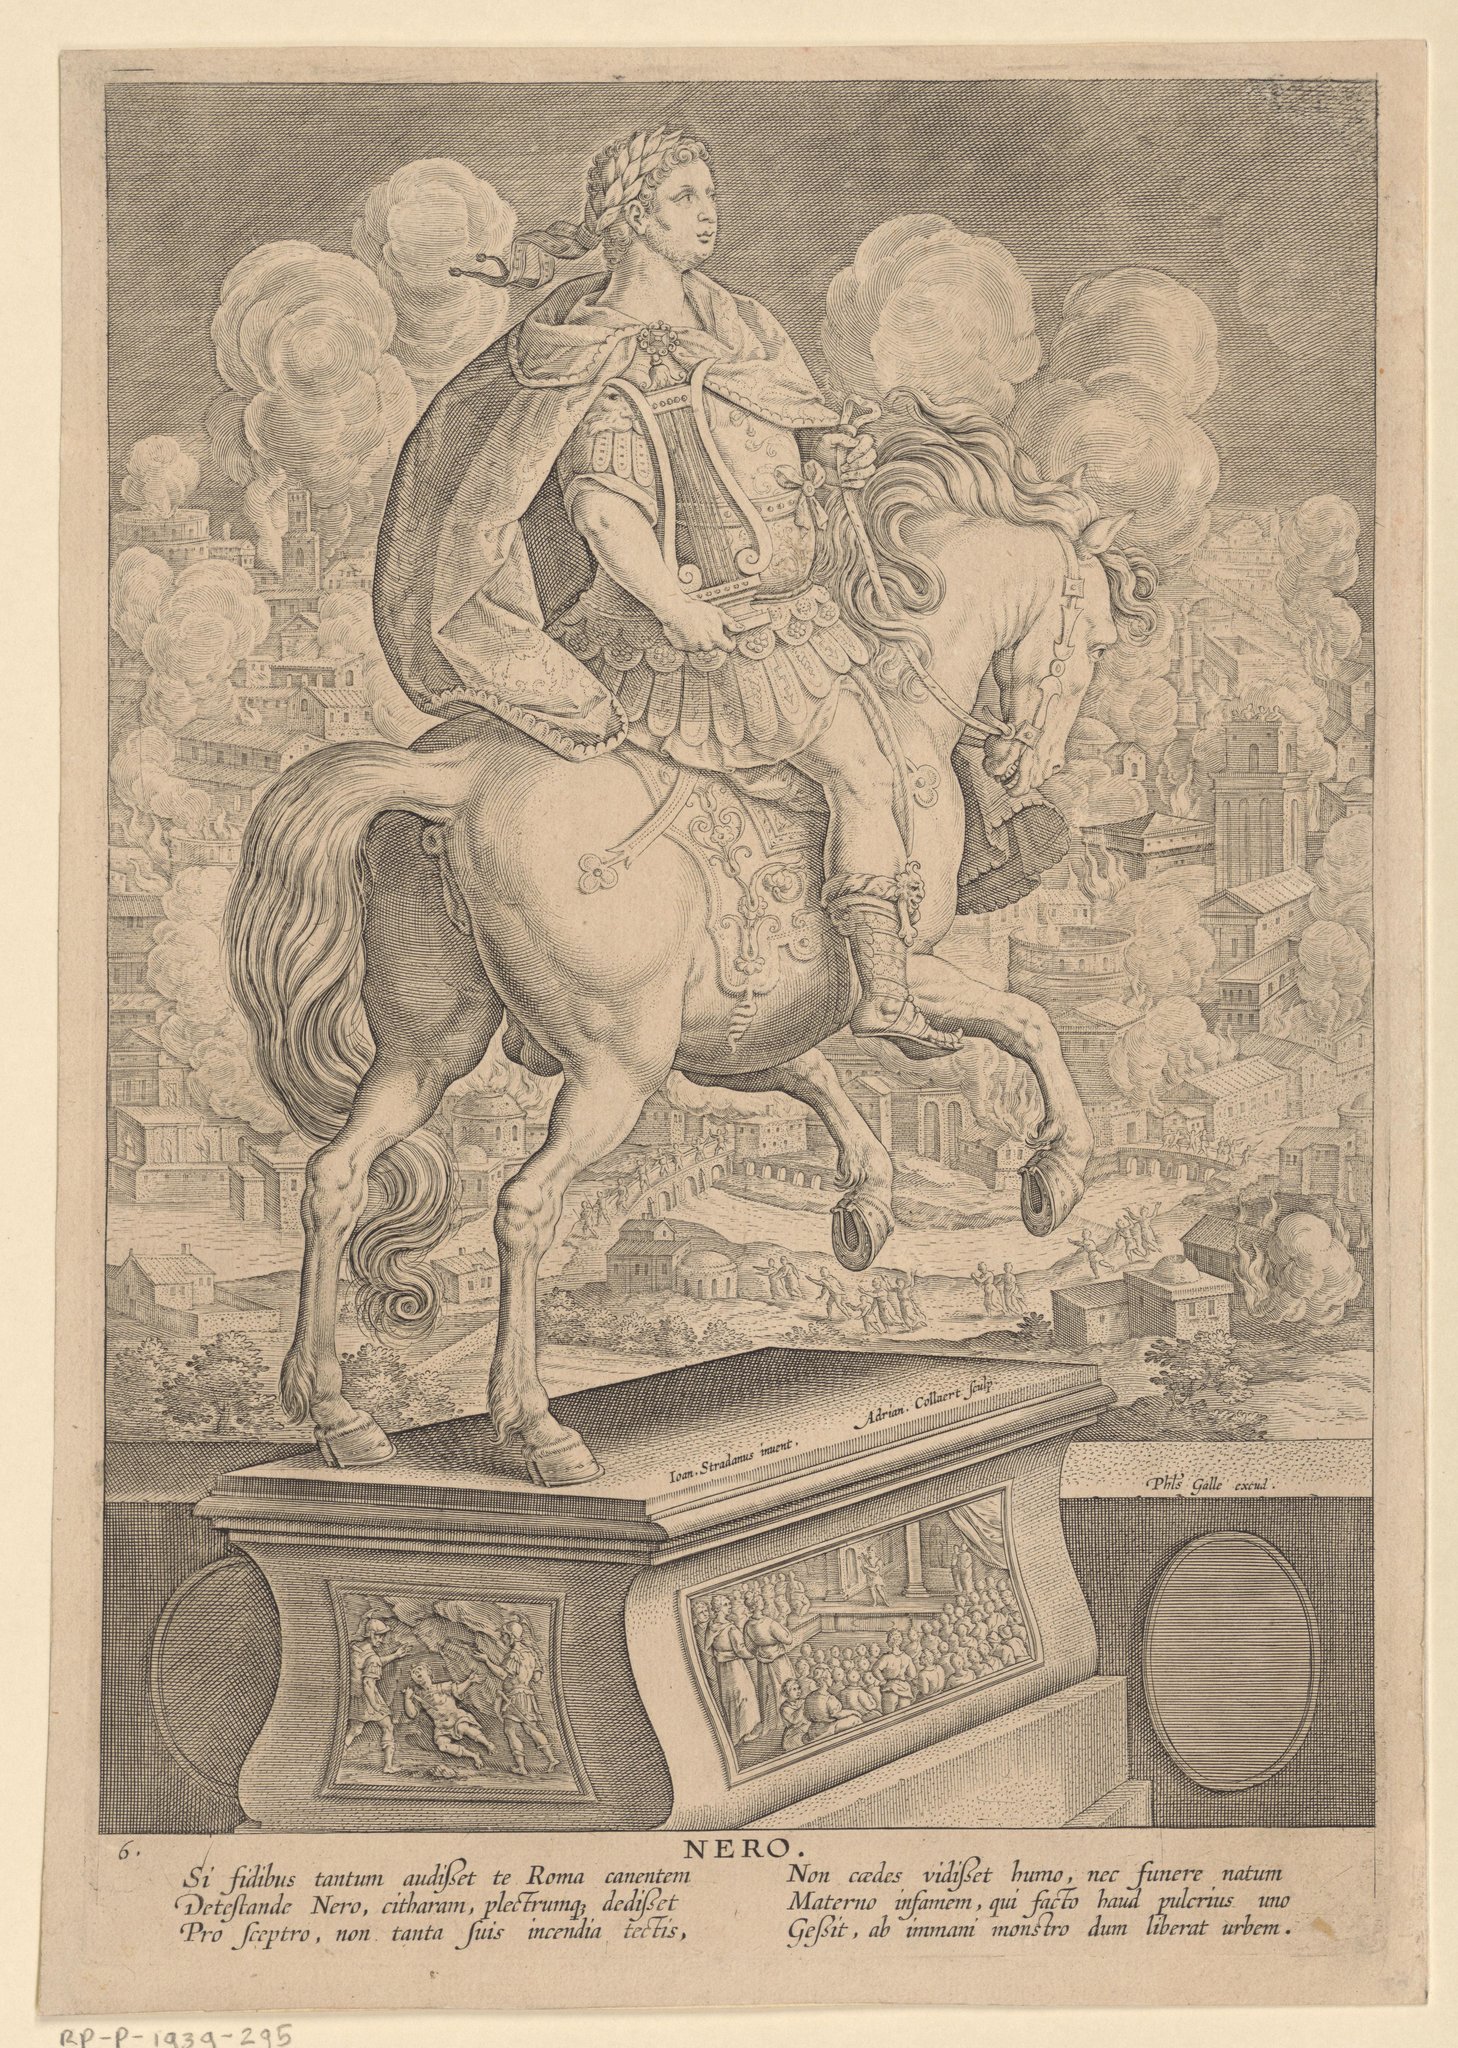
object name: print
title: Ruiterportret van Nero, keizer van het Romeinse Rijk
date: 1587-1589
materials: paper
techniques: engraving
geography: antwerp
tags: equestrian state-portrait, historical persons, (story of) nero, the roman emperor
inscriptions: collector's mark: Lugt 2760, collector's mark: Lugt 2228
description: Keizer Nero zittend op een paard met een lier in zijn hand. Op de achtergrond mensen die vluchten uit de brandende stad Rome. Linksonder genummerd: 6.